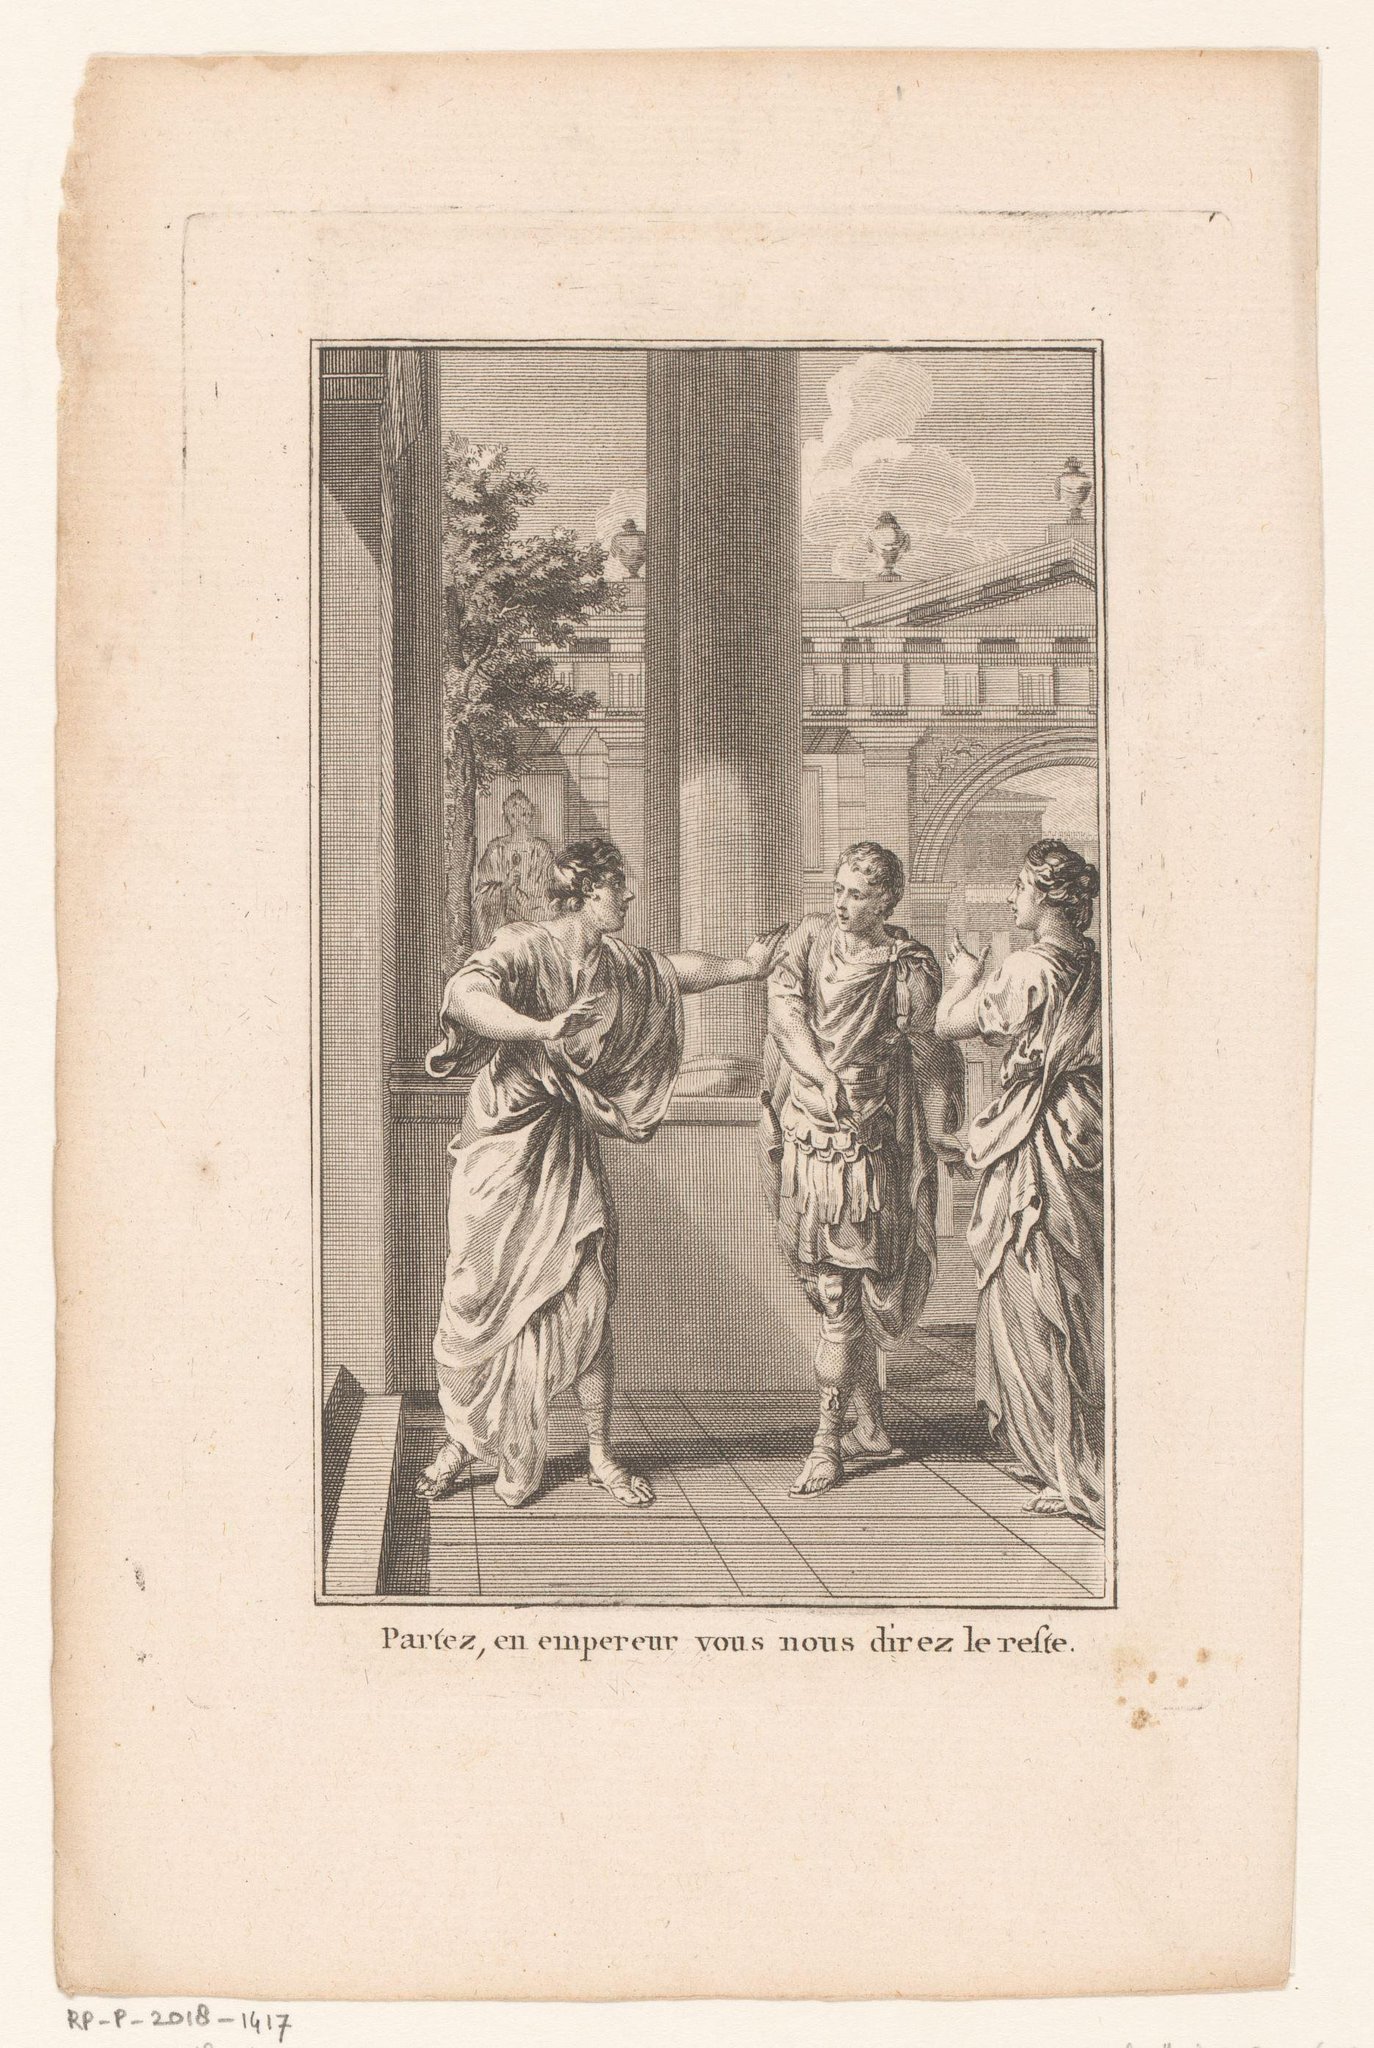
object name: print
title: Scène uit Othon met drie figuren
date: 1763-1764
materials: paper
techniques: etching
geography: geneva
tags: theatre, theatrical performance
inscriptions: collector's mark: Lugt 2228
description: Prent uit: Corneille, Pierre. Théâtre (...). Genève: Cramer, 1764. Dit betreft een illustratie op p. 131 uit deel 8, getiteld 'Othon'.